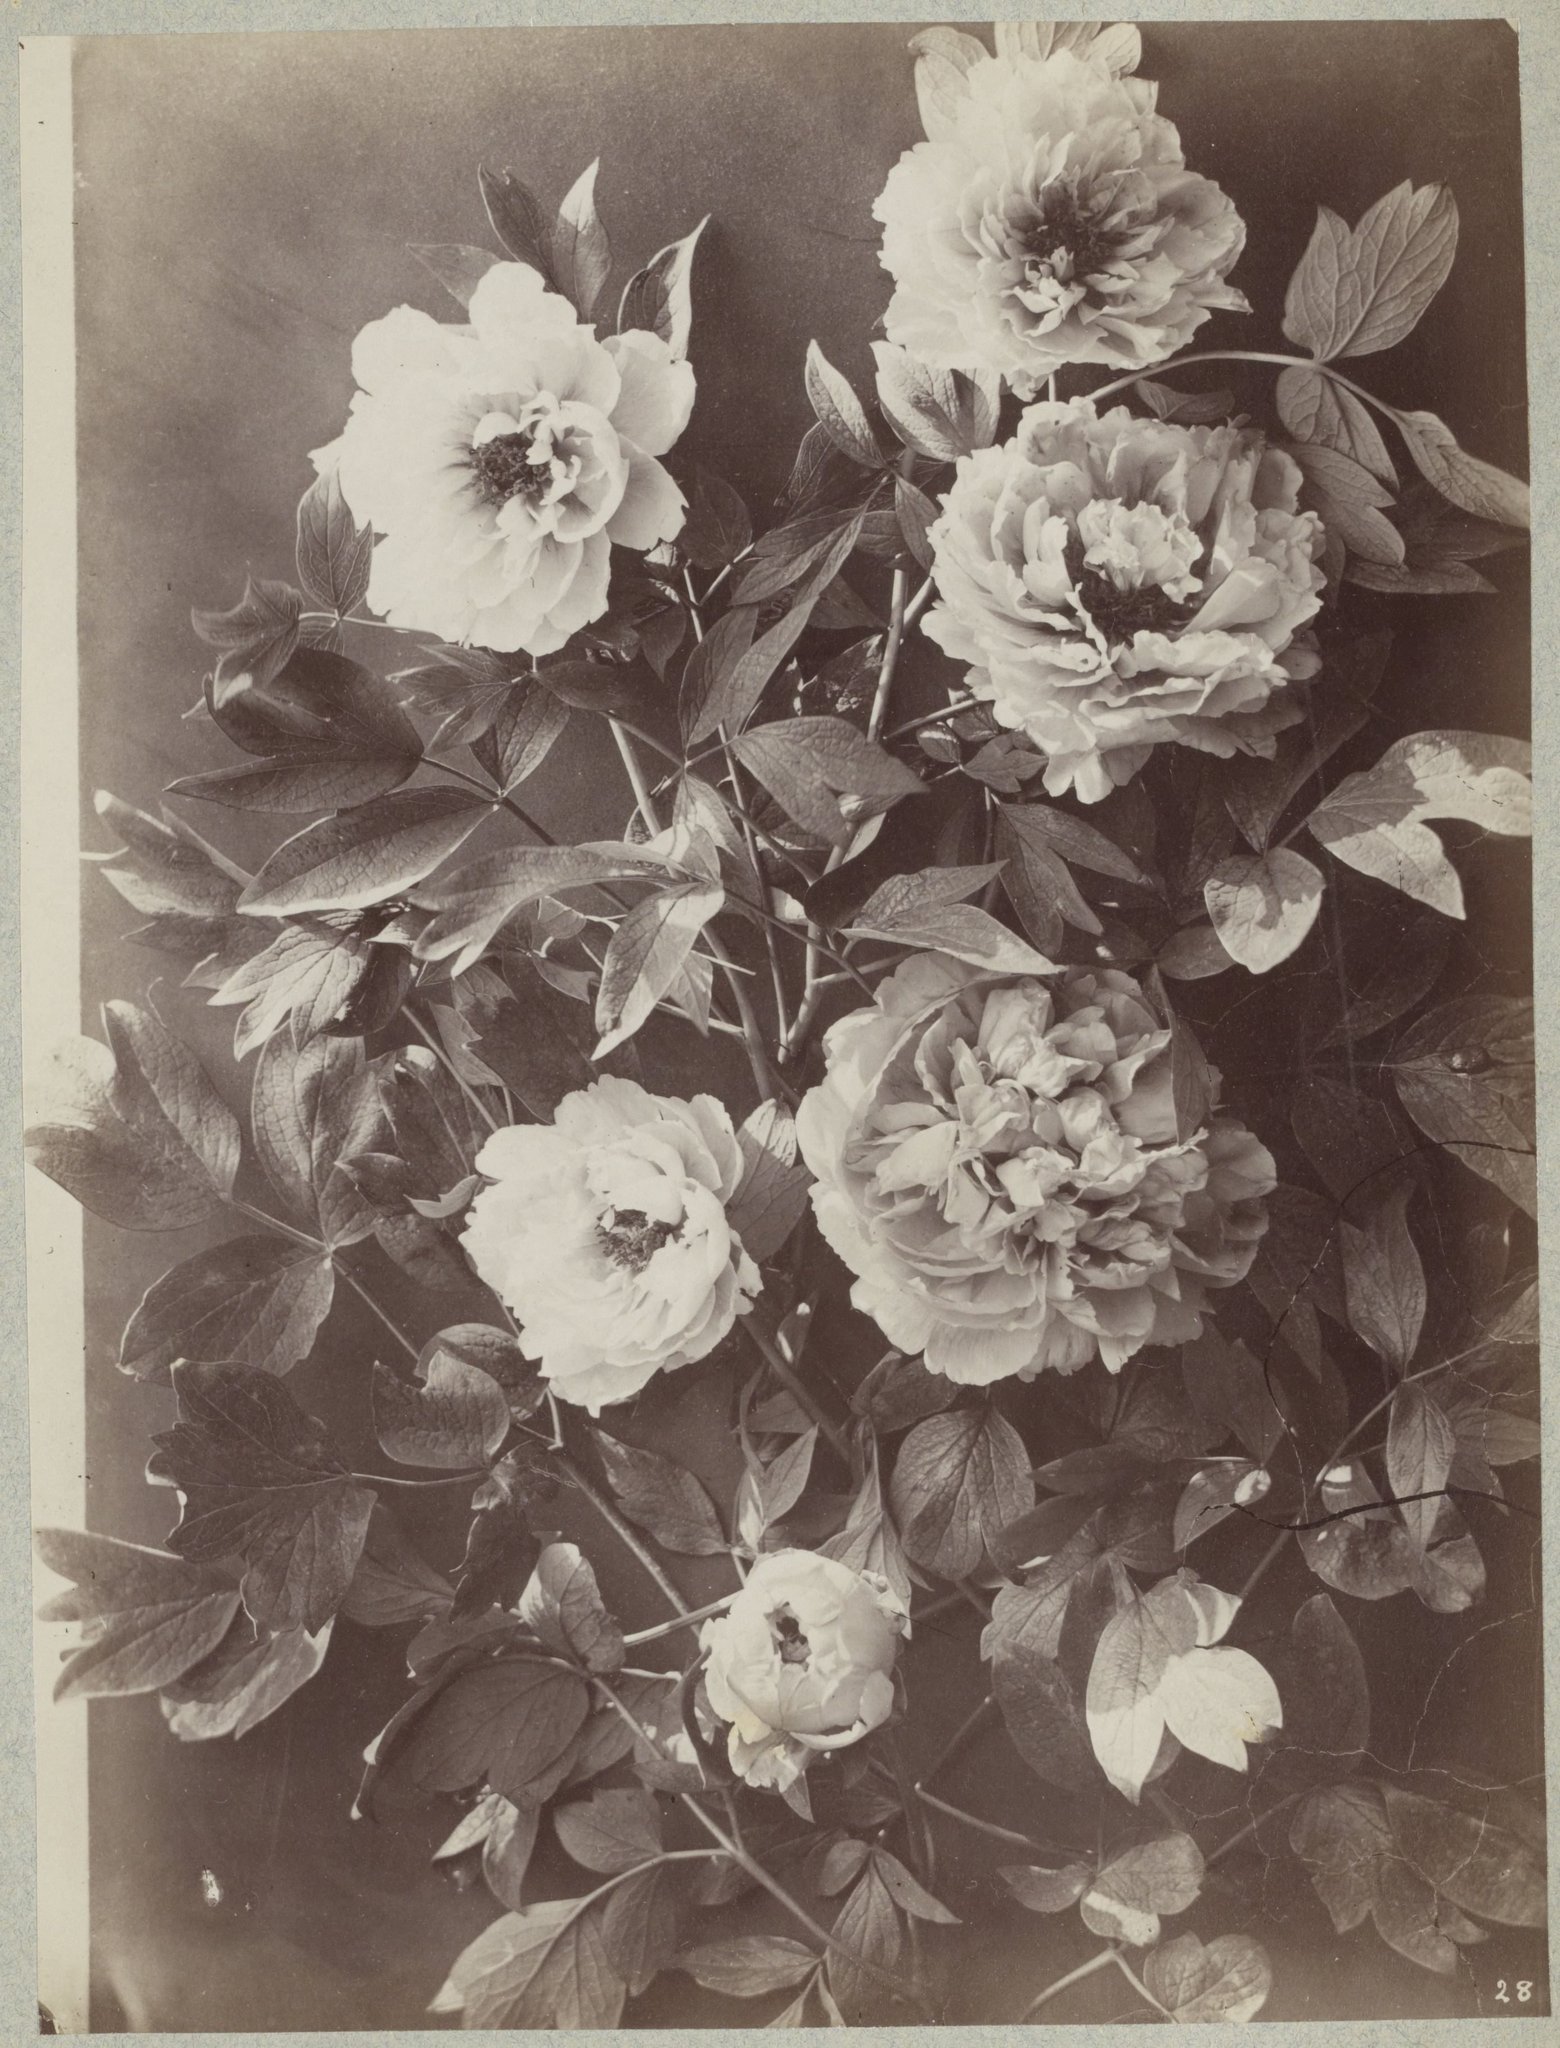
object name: photograph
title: Bloemstudie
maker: a. calavas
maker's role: publisher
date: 1875-1895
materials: cardboard, photographic support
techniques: albumen print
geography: paris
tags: flowers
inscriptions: number: ‘28’, collector's mark: Lugt 3937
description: Onderdeel van Verzamelband met foto's van bloemstudies.